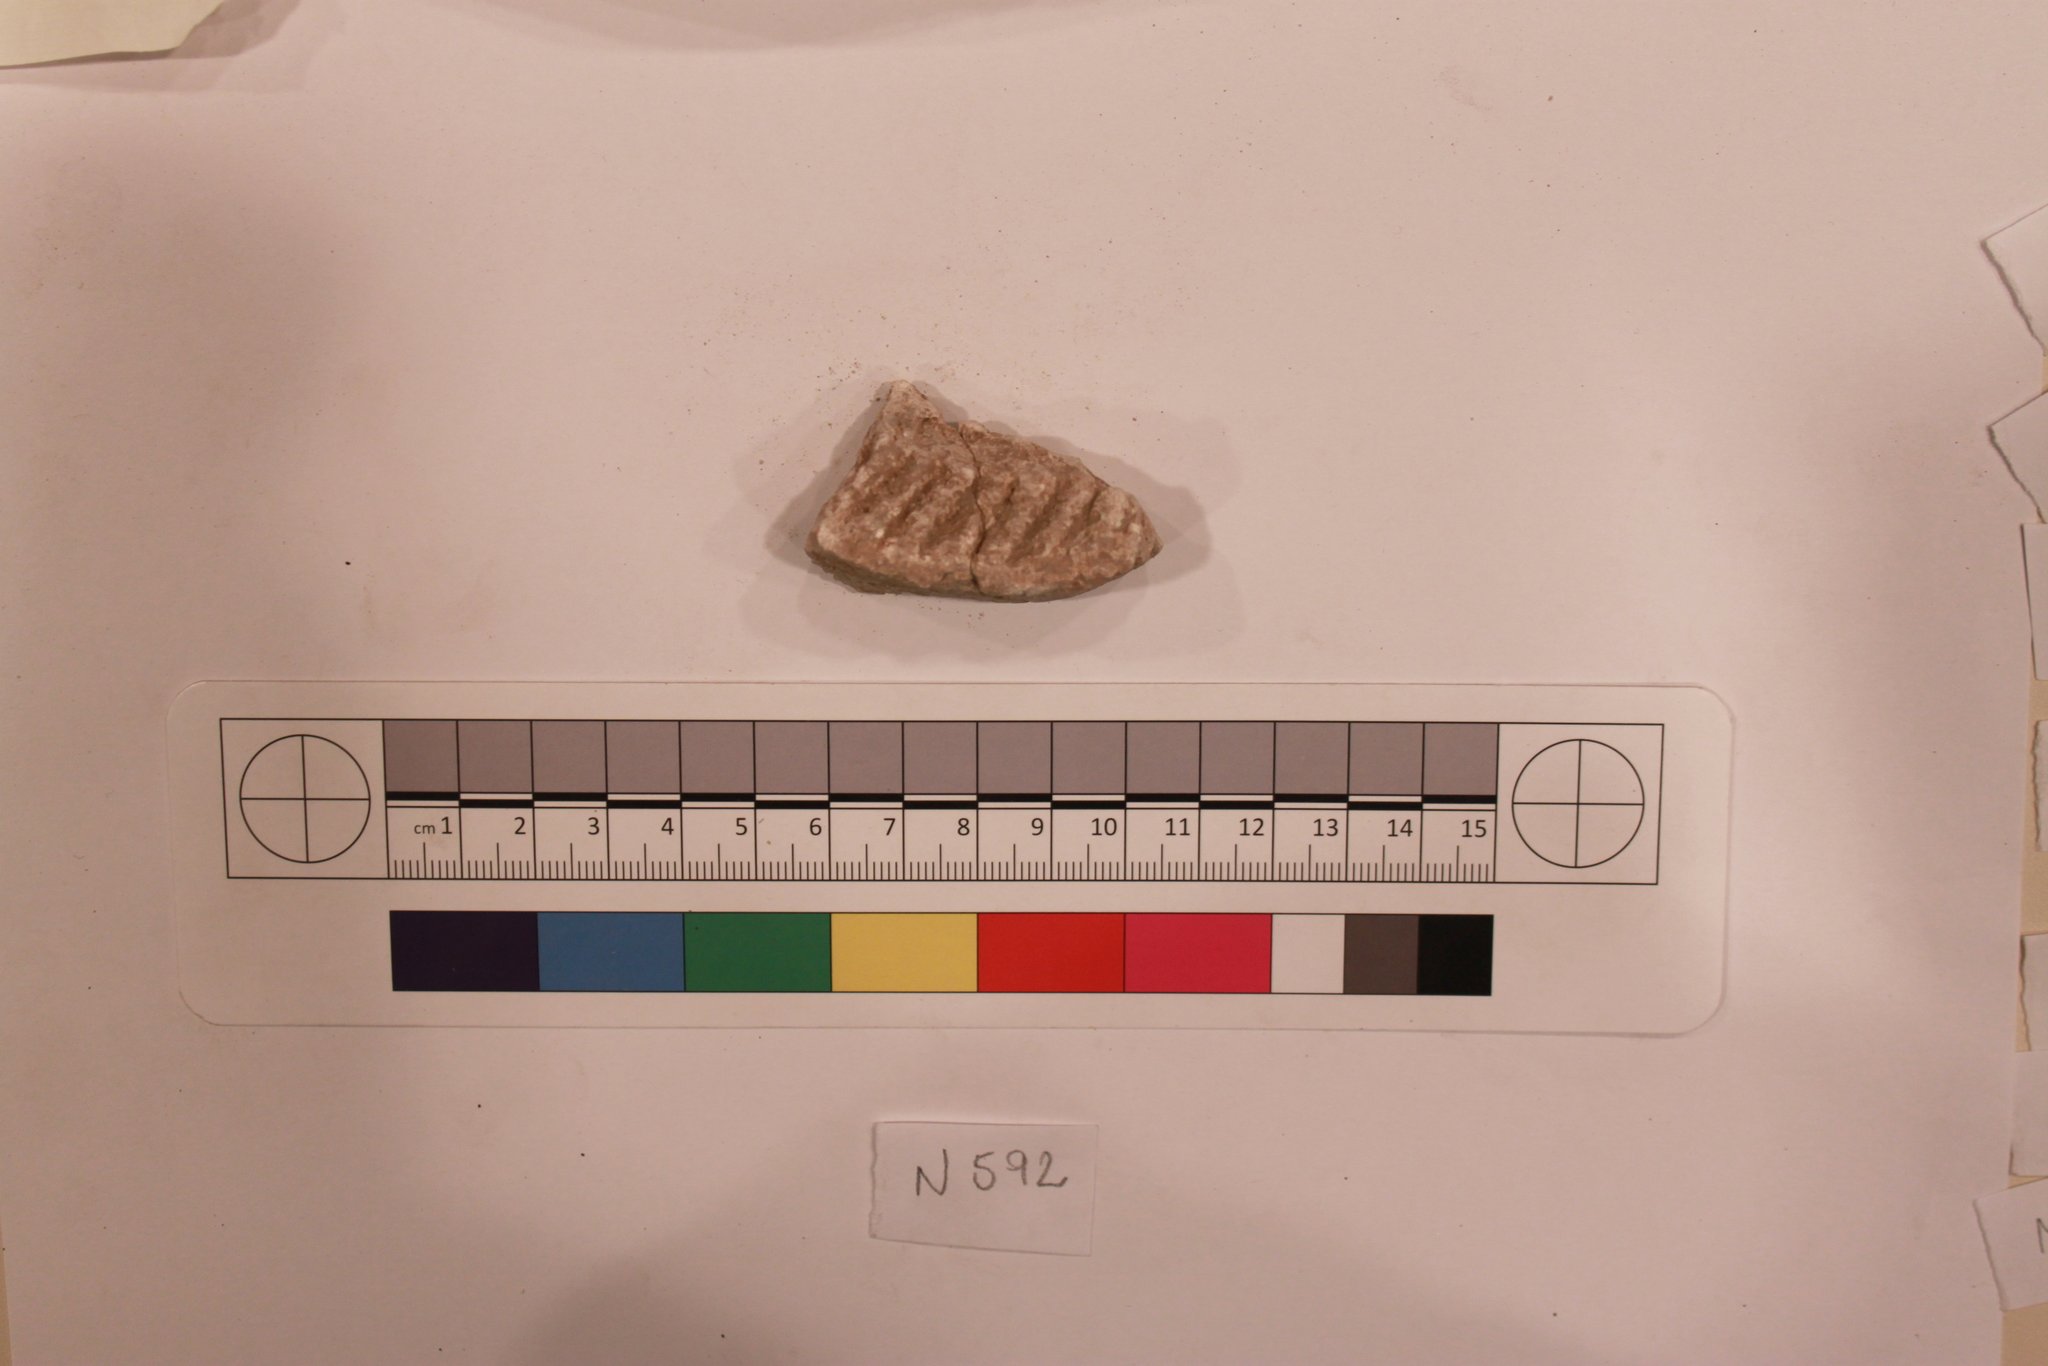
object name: fragment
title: Stucco Fragment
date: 701-1200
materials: plaster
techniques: carving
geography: iran